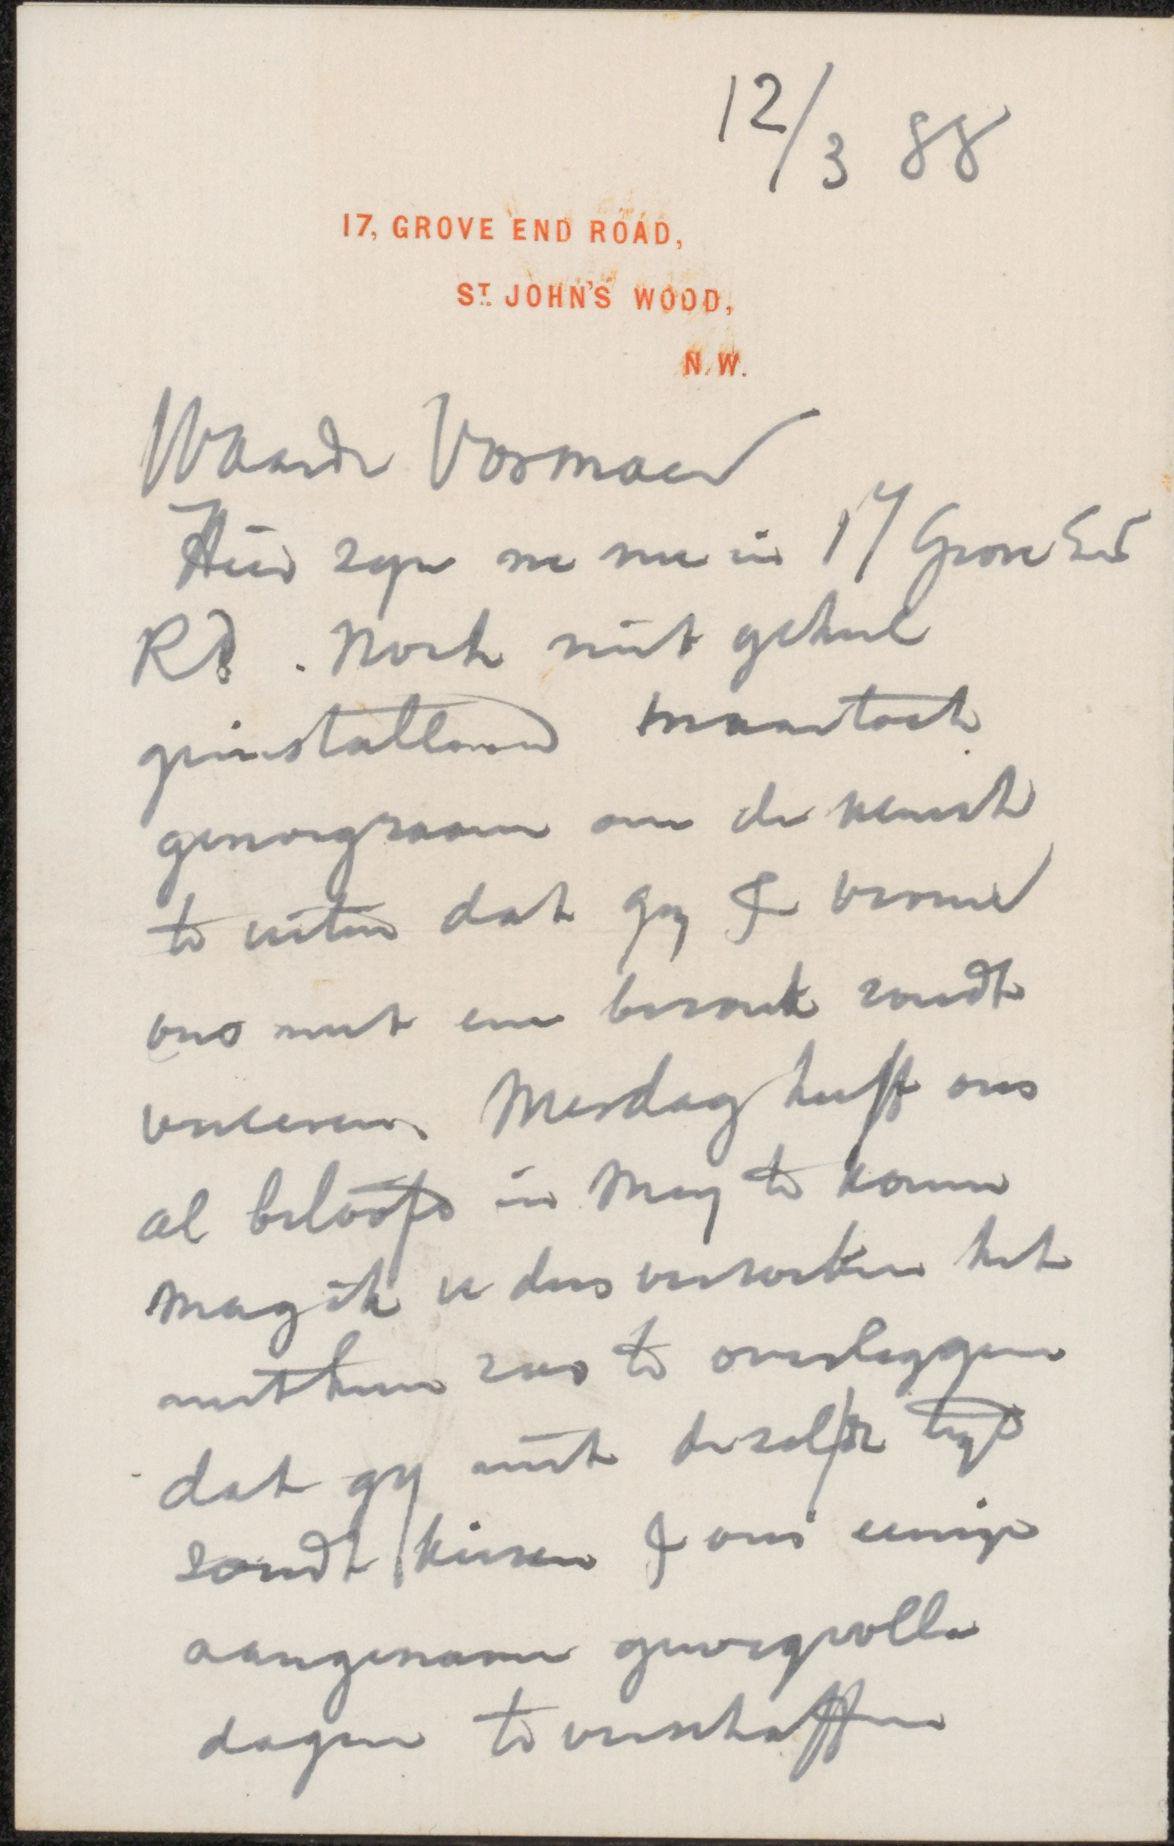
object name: letter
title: Brief aan Carel Vosmaer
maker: lourens alma tadema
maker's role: draughtsman, print maker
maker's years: 1836-1912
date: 1888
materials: ink, paper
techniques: pen, printing, writing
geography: london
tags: the hague, print maker, draughtsman, carel vosmaer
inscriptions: watermark